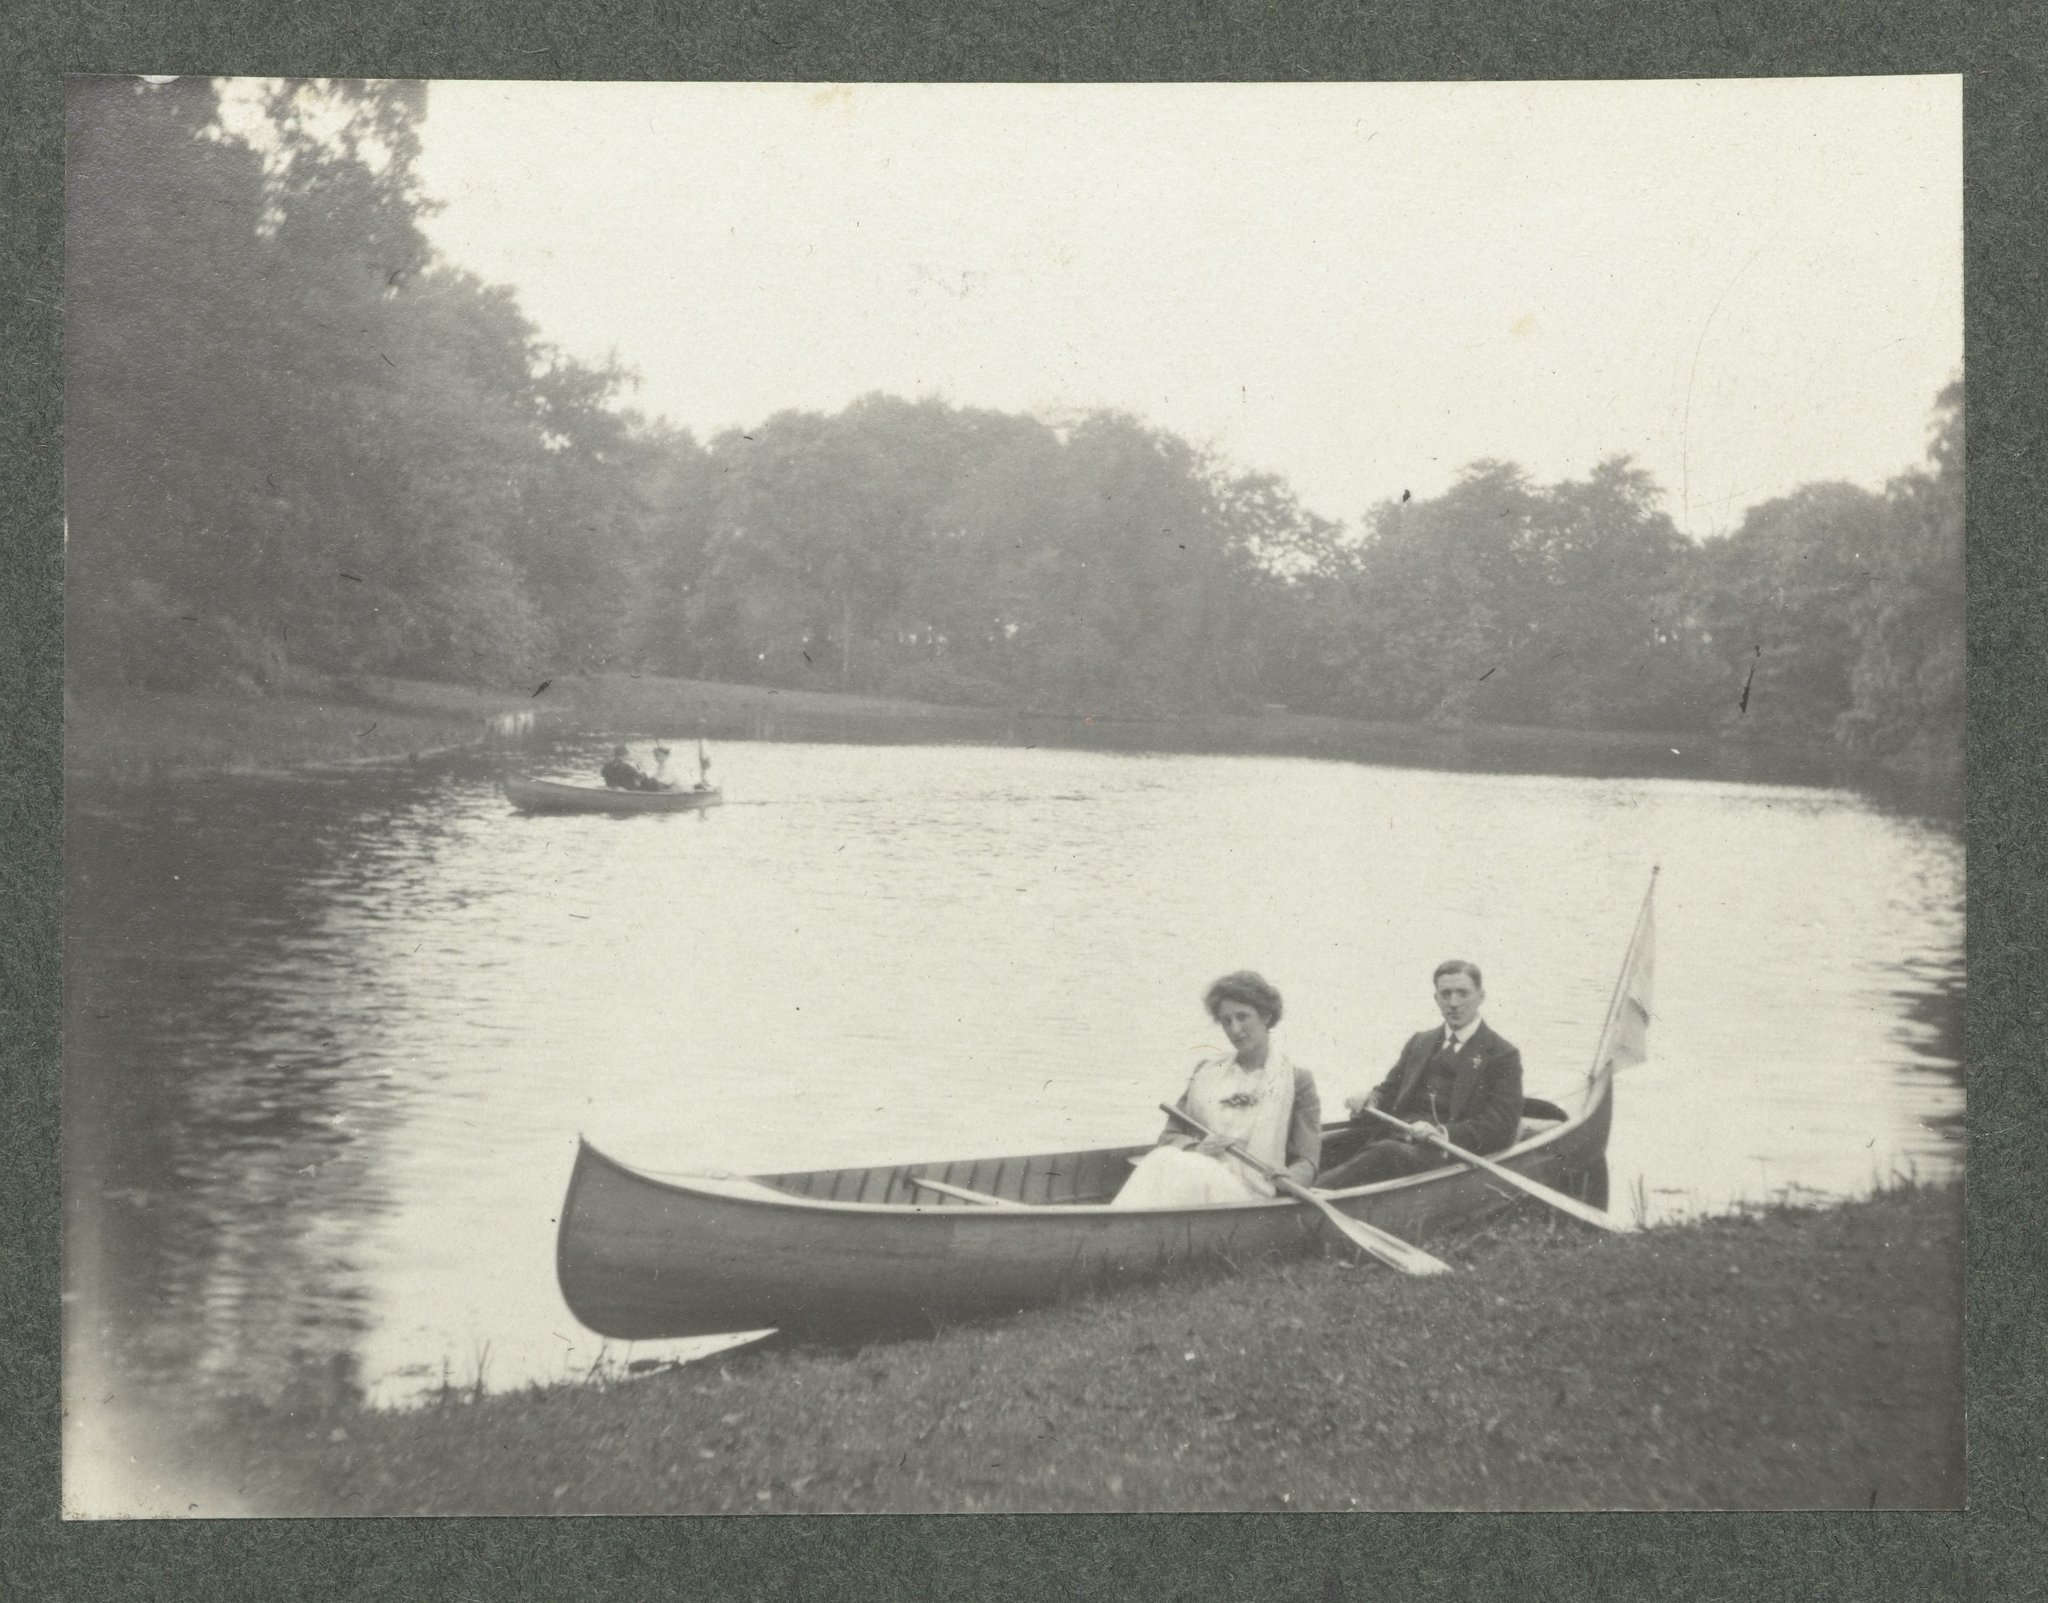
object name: photograph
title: De Canadees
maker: geldolph adriaan kessler (dolph)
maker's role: fotograaf, industrieel, voetballer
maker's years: 1884-1945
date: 1913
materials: paper, photographic support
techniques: photography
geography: netherlands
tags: official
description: Portret van Johannes Cornelis Heijning en Margaretha Eugenia Fransen van de Putte in een Canadese kano aan de rand van een vijver.